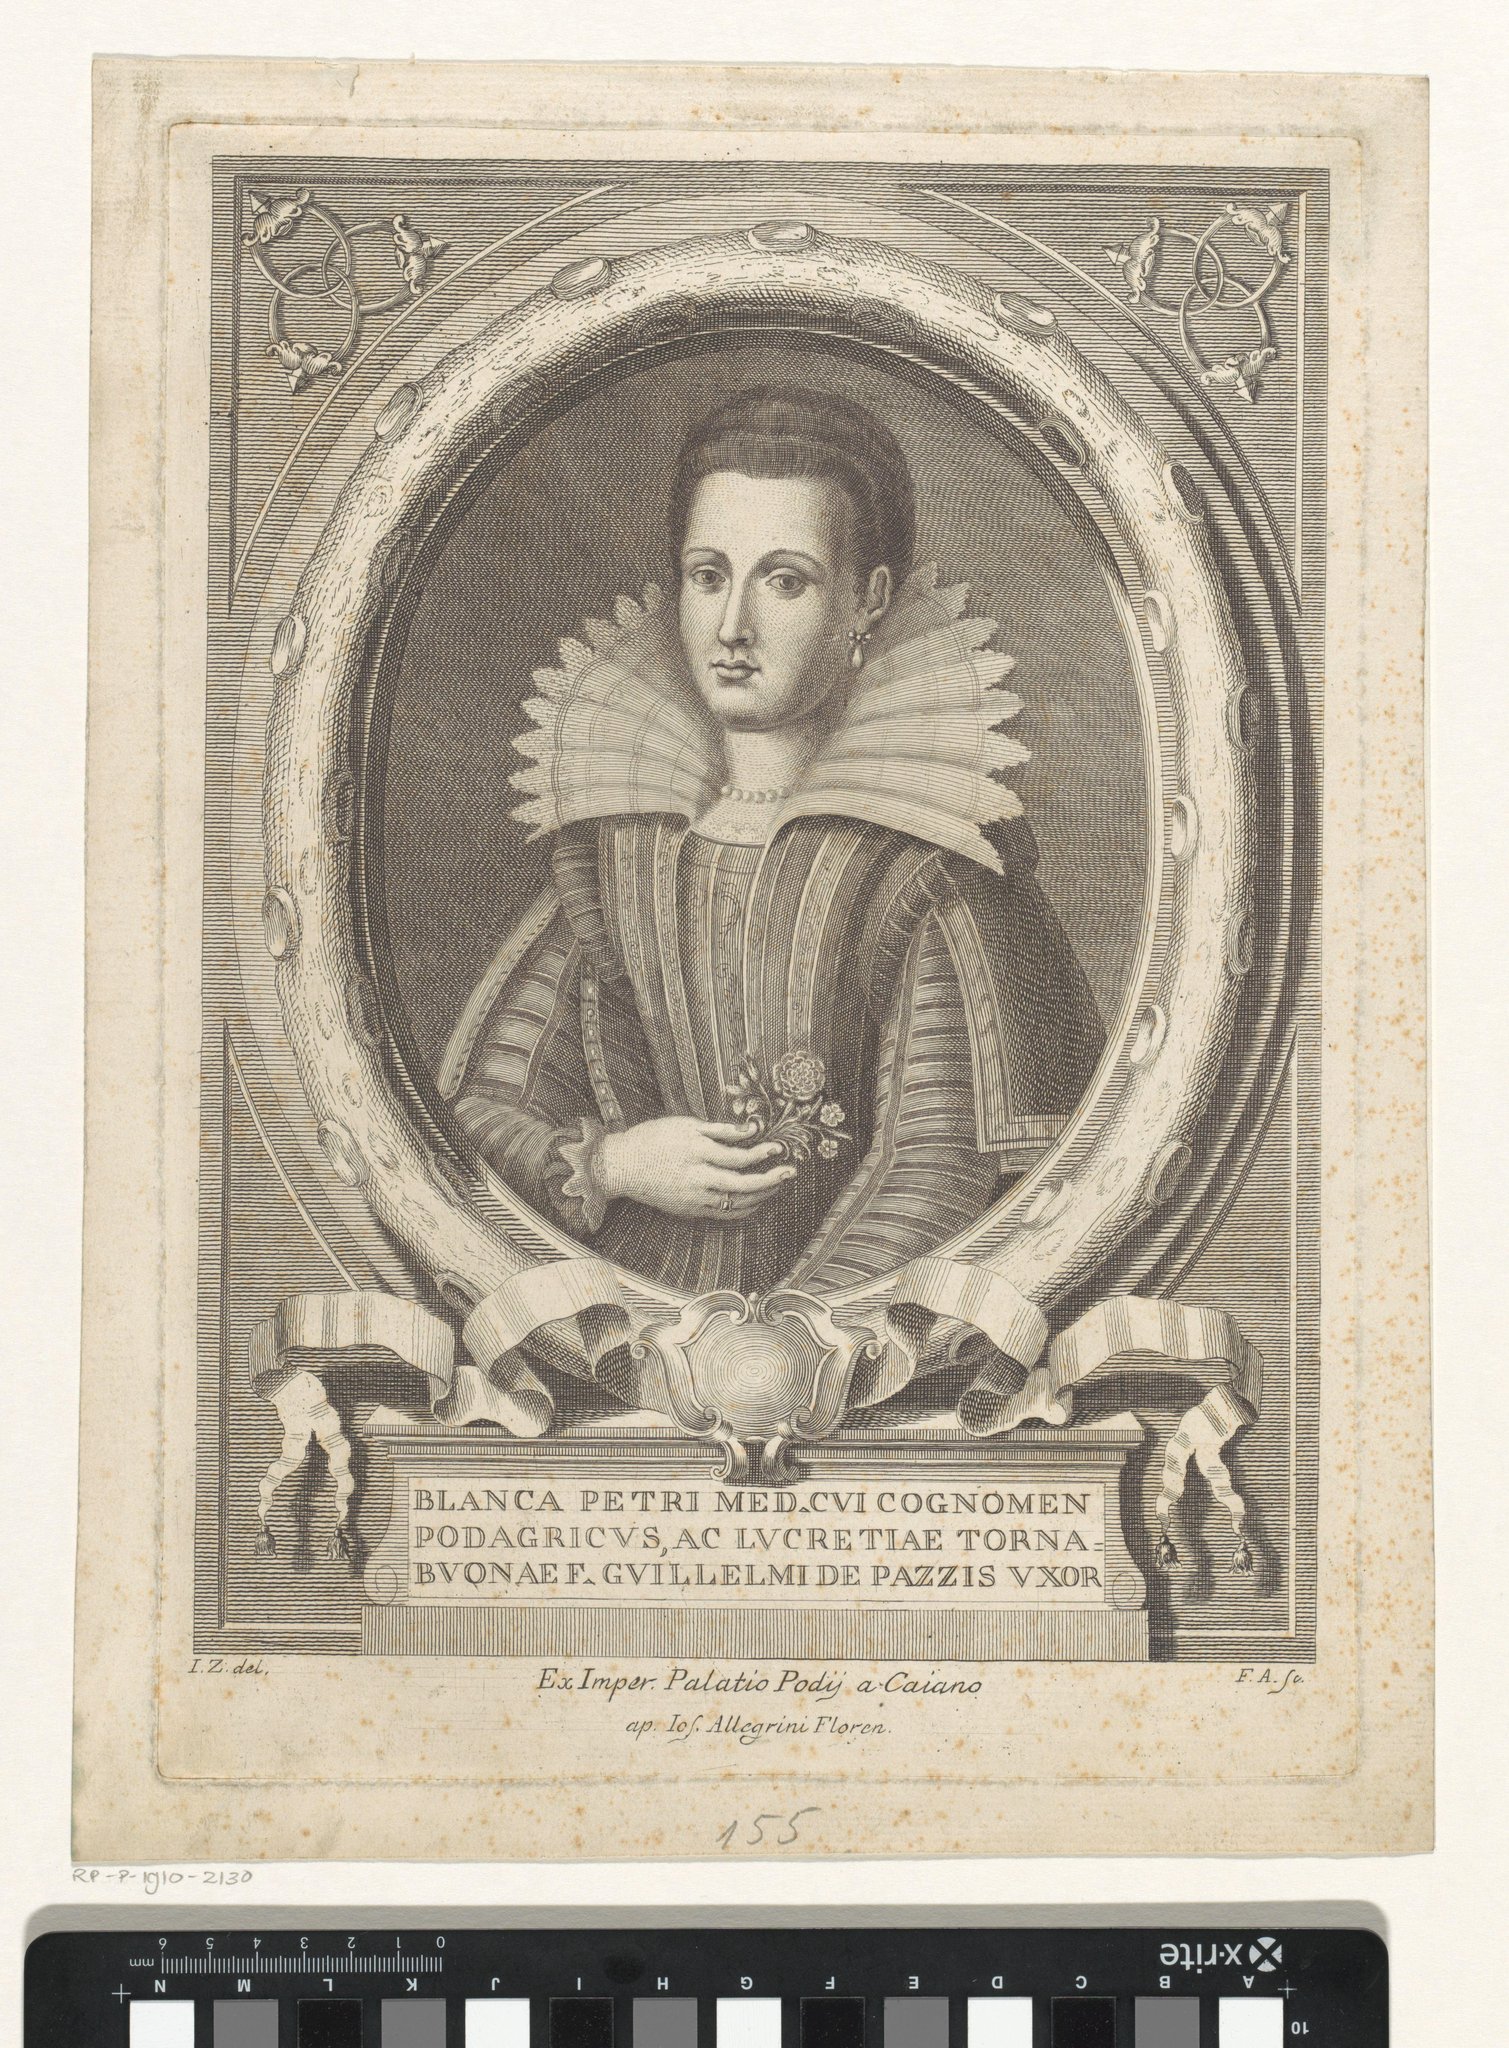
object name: print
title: Portret van Bianca de' Medici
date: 1739-1773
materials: paper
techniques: engraving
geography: italy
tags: historical persons - bb - woman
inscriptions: collector's mark: Lugt 2228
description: Portret van Bianca de' Medici in ovale lijst met onder een leeg cartouche. In haar rechterhand een bloem. Onder het portret een kader met haar naam.